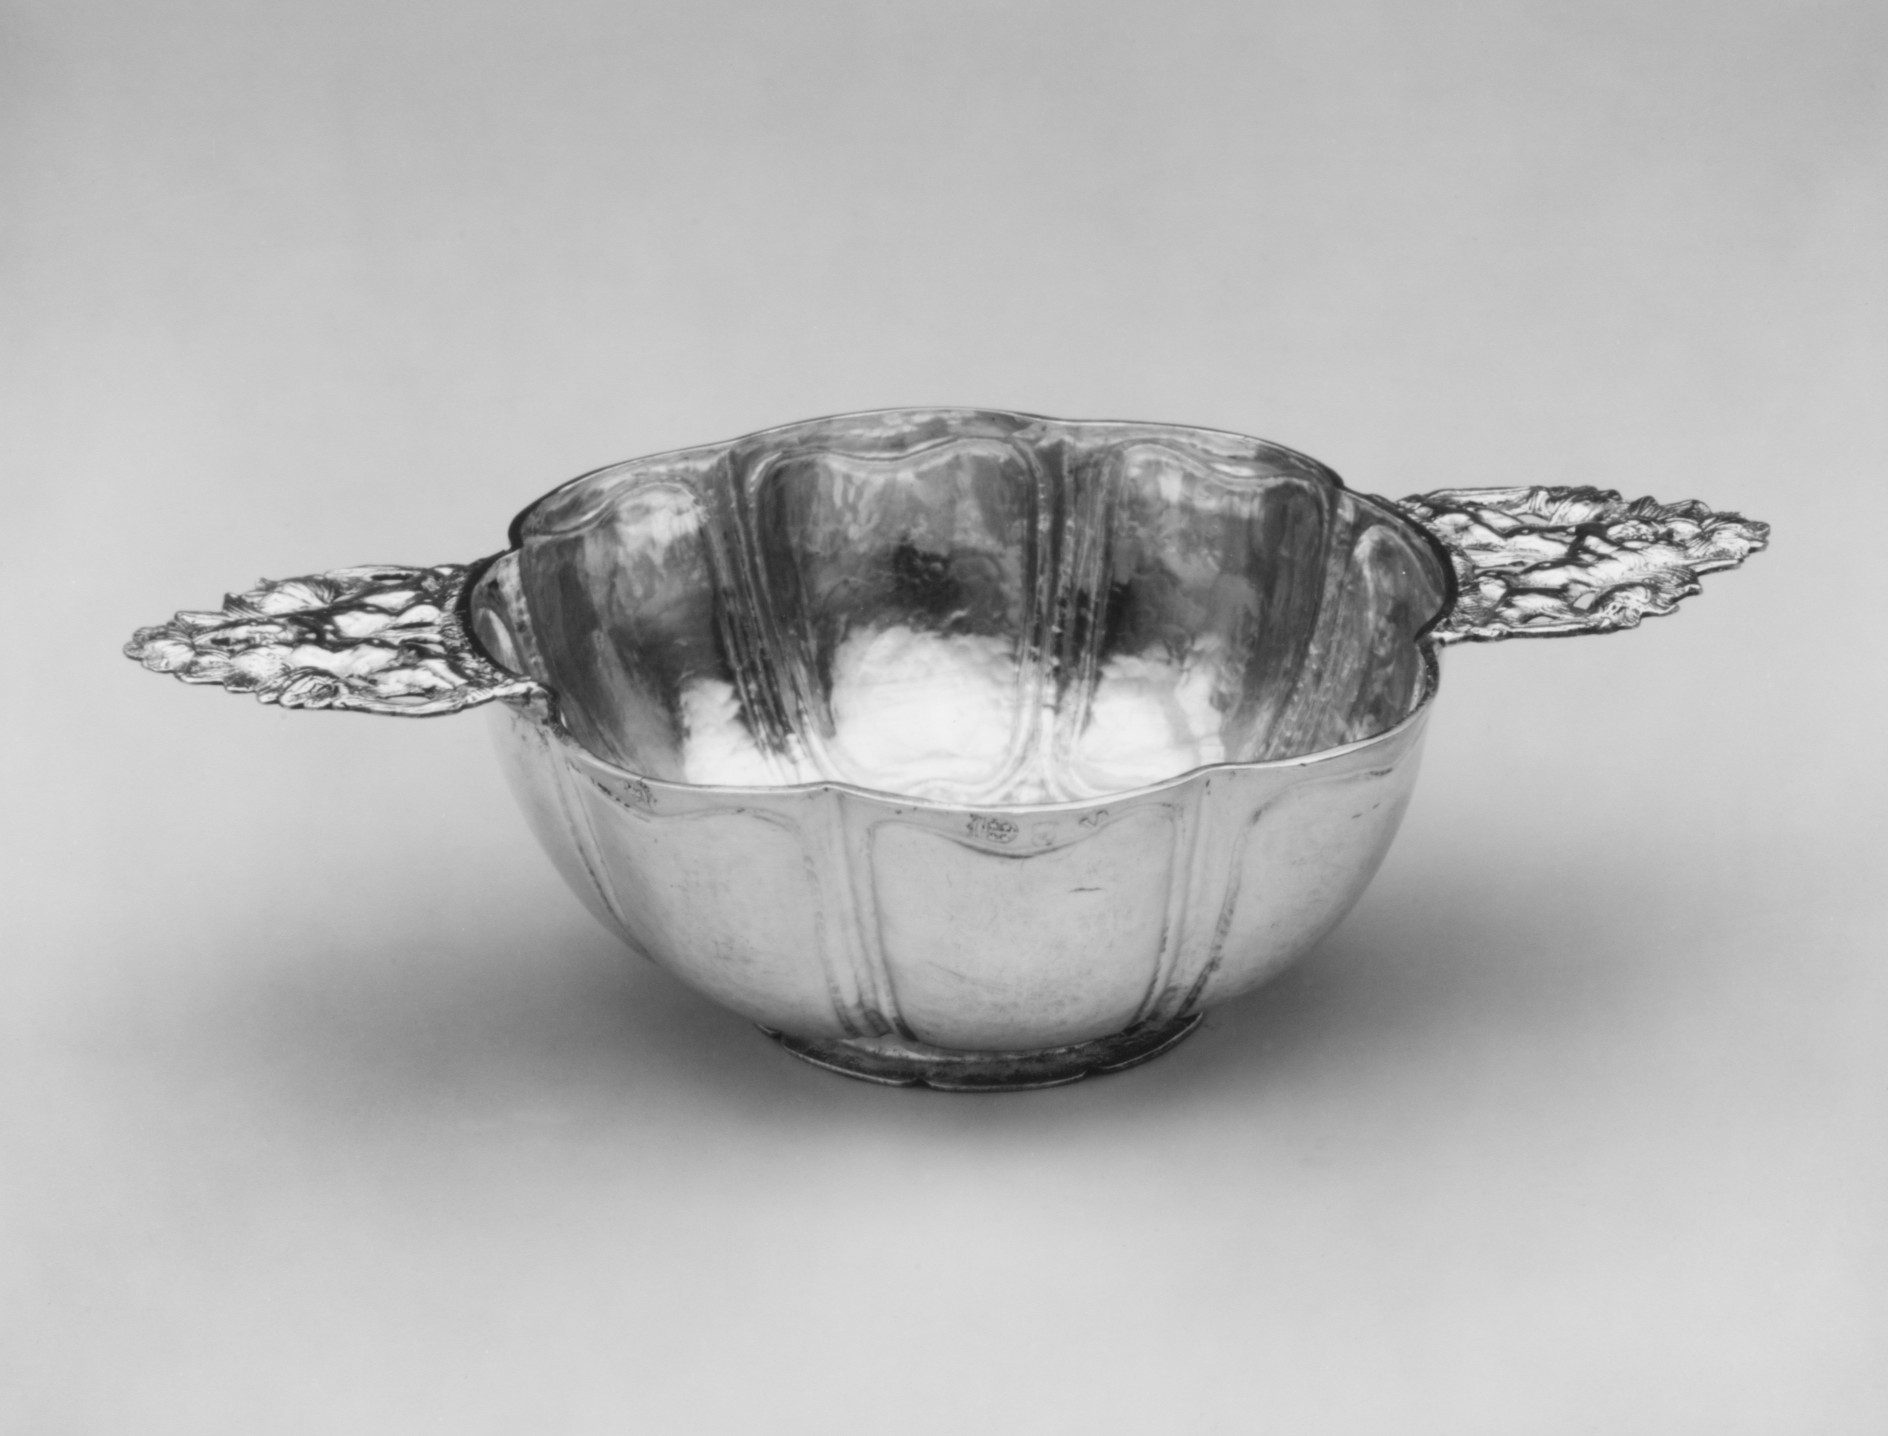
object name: brandy bowl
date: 1682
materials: silver